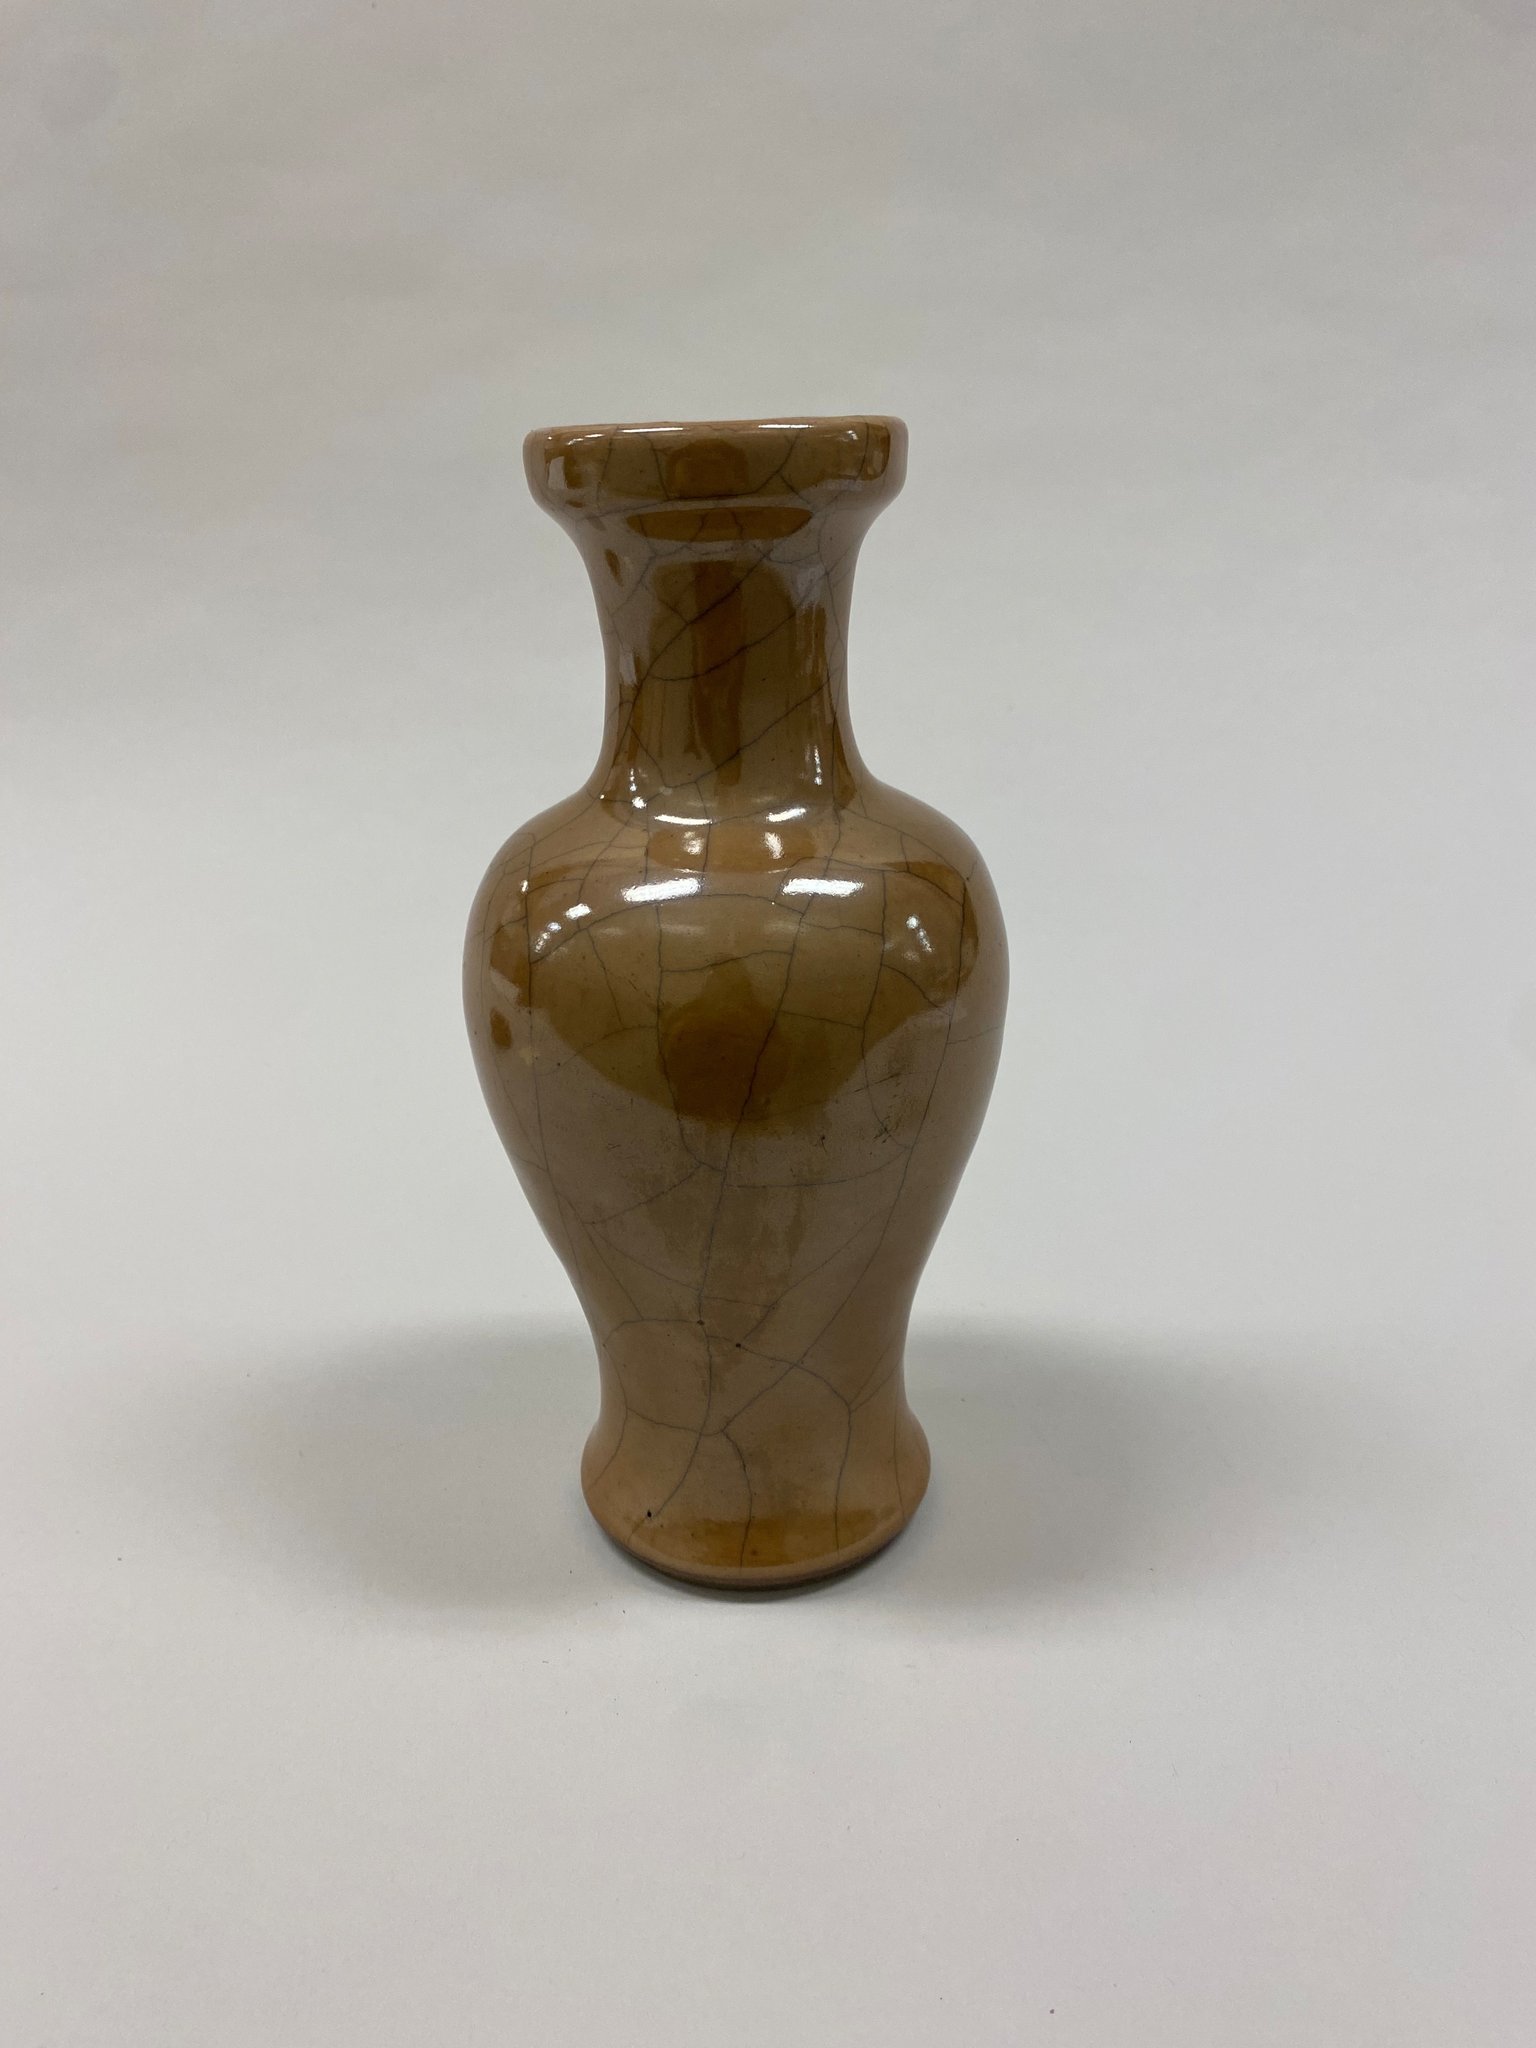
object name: vase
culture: chinese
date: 1667-1733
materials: glaze, porcelain